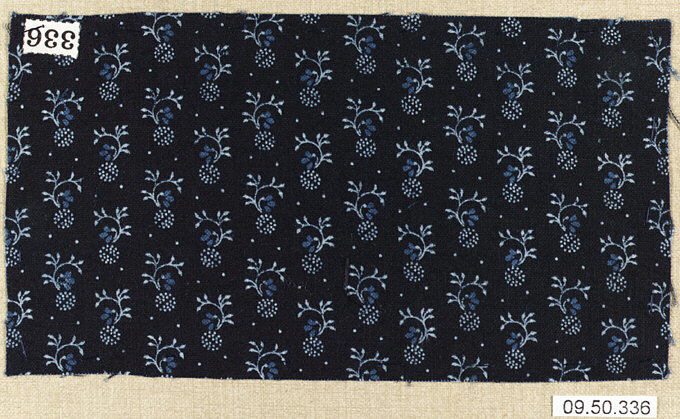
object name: piece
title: Piece (one of 116)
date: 1801-1900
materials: cotton